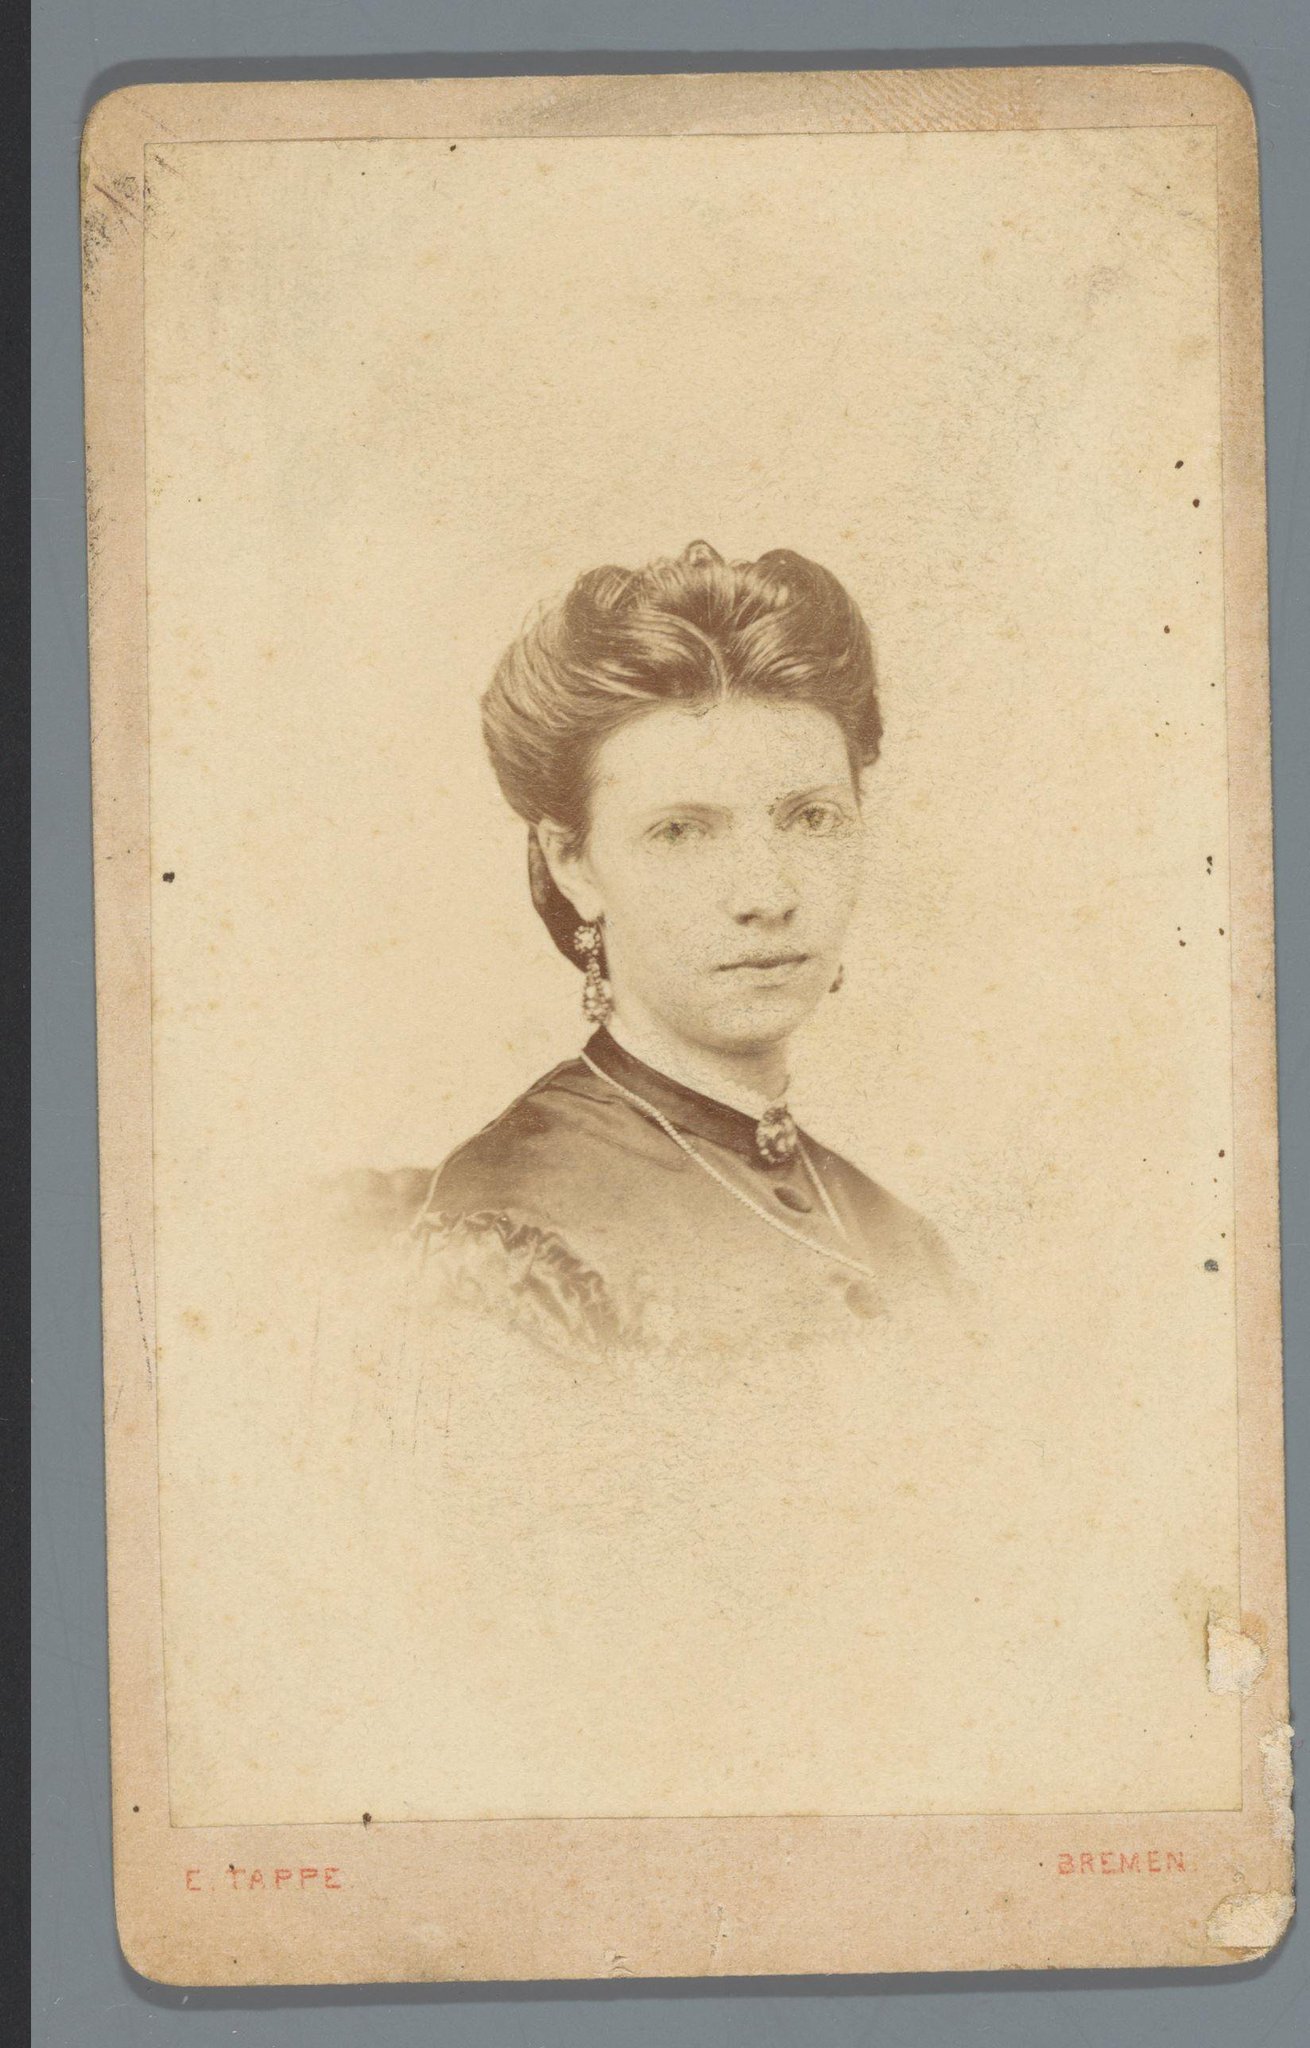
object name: photograph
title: Portret van een onbekende vrouw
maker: emil tappe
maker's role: fotograaf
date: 1855-1885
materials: cardboard, paper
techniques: albumen print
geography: bremen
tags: adolescent, young woman, maiden, anonymous historical person portrayed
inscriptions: inscription: ‘Aus dem/ photographischen/ Salon/ von/ Emil Tappe/ Bremen/ Wall 154’, inscription: ‘E. Tappe Bremen’